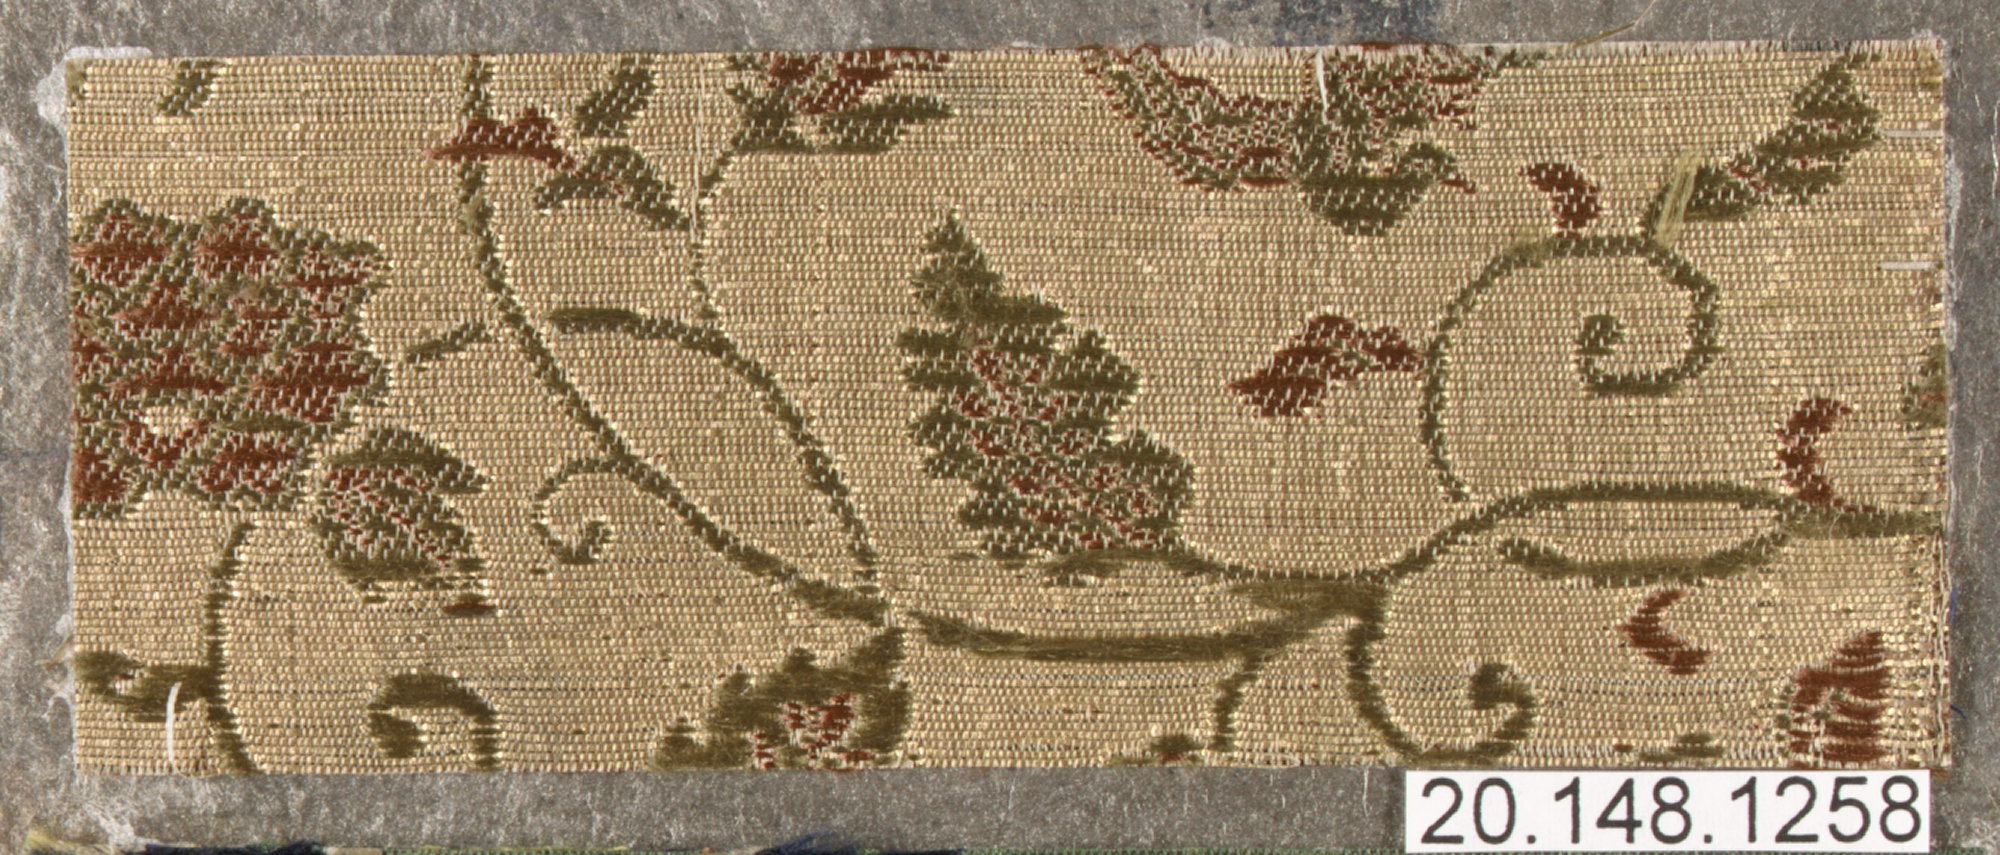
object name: piece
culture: japanese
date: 1701-1800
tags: leaves